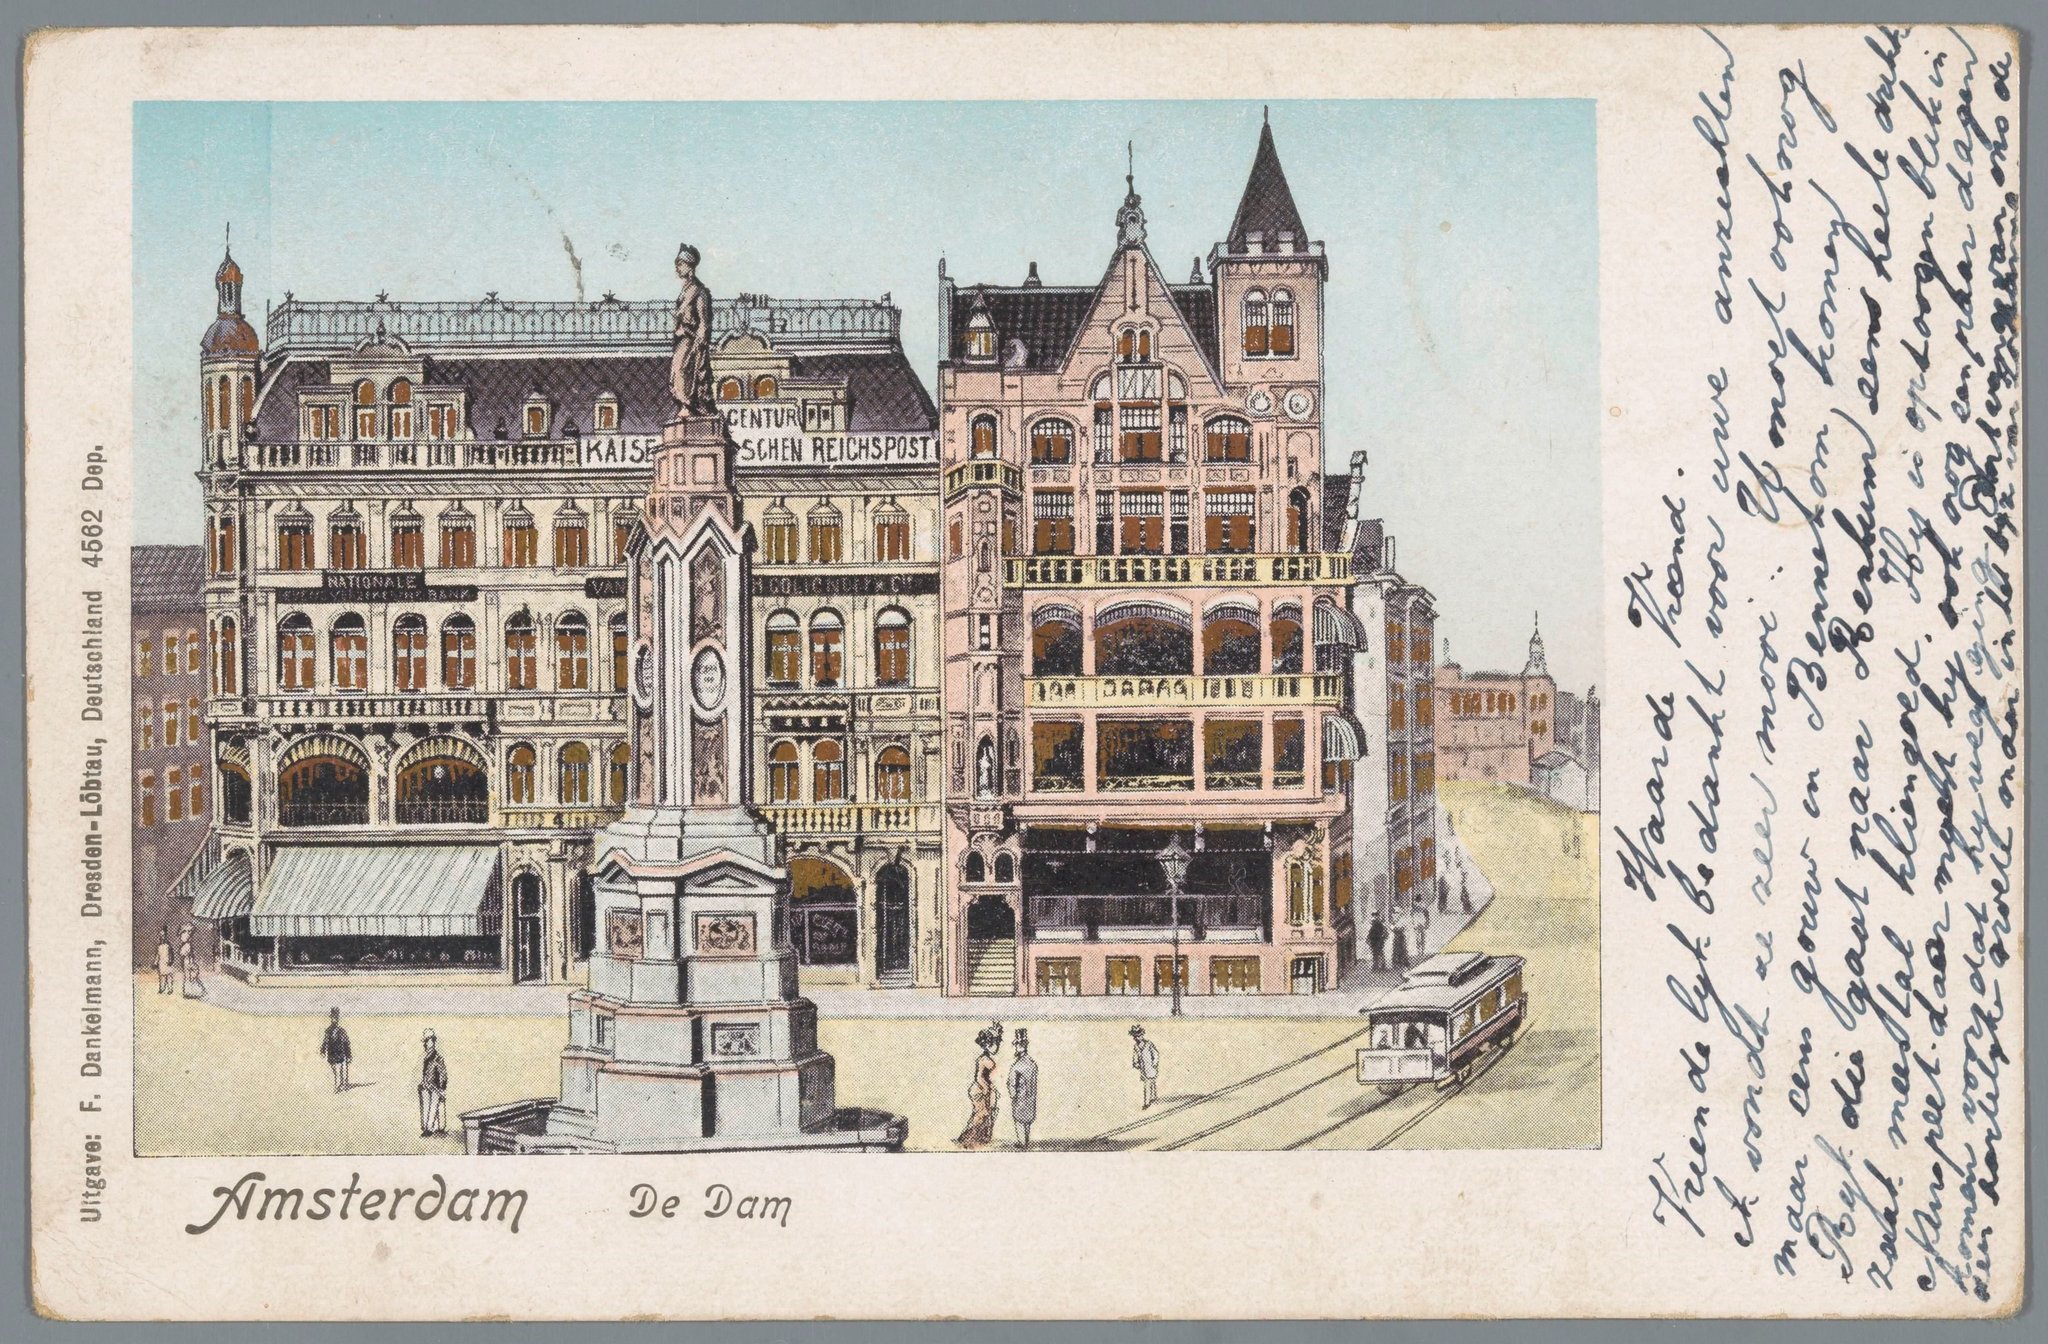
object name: ansichtkaart, prentbriefkaart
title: Amsterdam, De Dam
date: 1902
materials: cardboard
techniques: lithograph, writing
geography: dresden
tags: square, place, circus, etc.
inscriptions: inscription: ‘Uitgave: F. Dankelmann, Dresden-Löbtau, Deutschland 4562 Dep.’